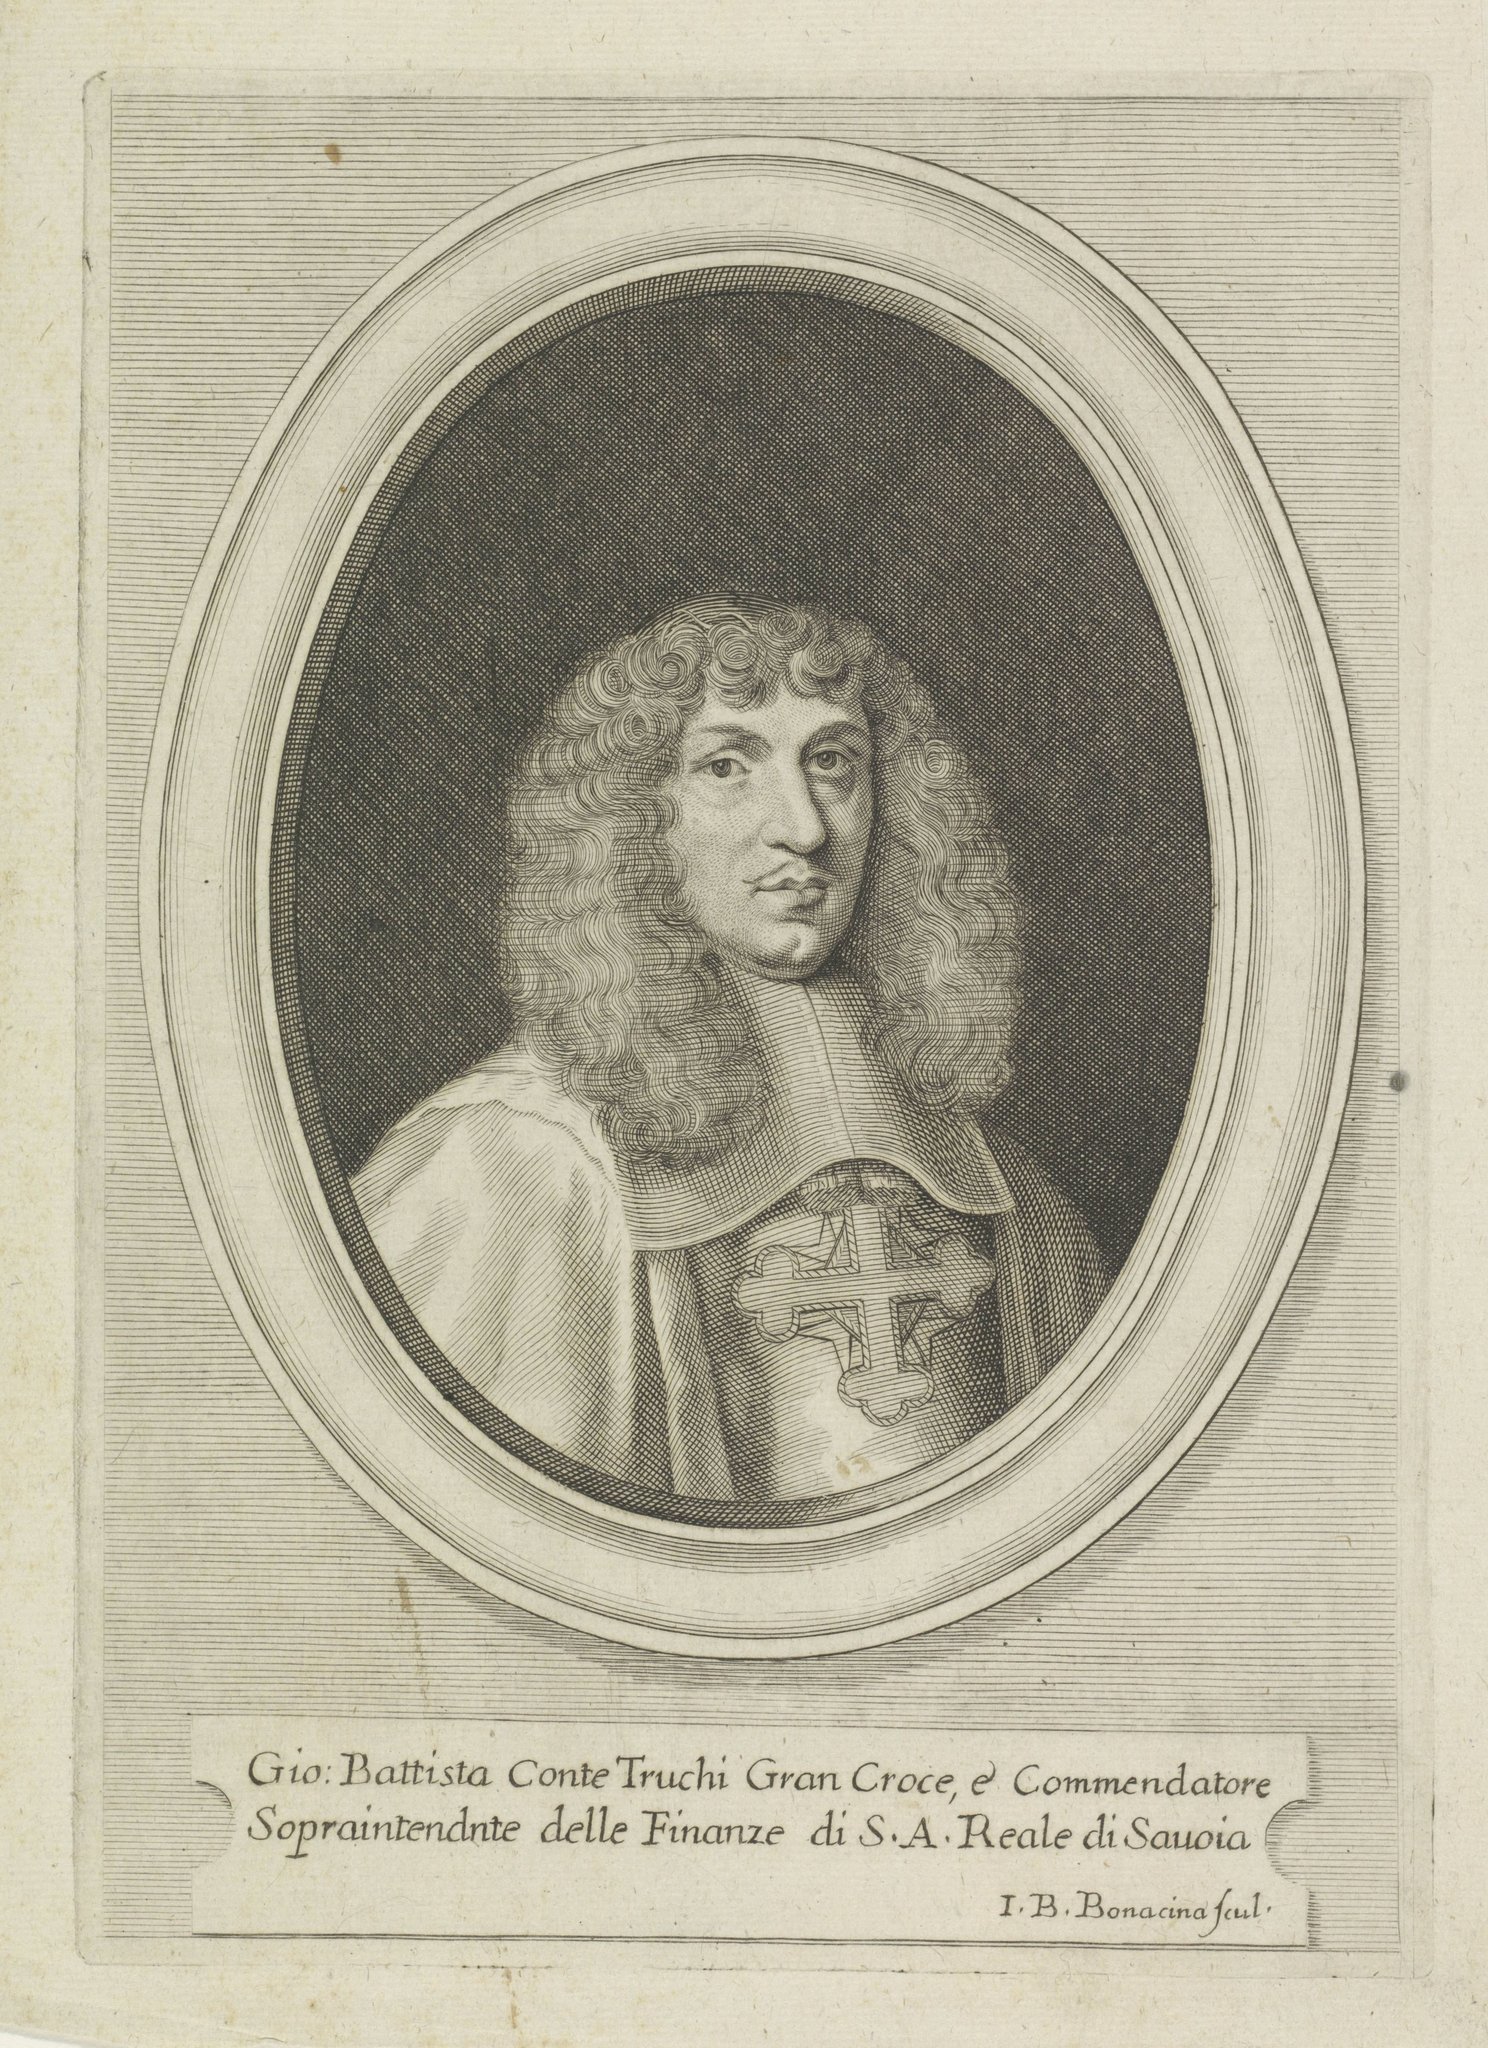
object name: print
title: Portret van Giovanni Battista Truchi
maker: giovanni battista bonacina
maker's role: print maker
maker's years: 1615-1669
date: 1625-1669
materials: paper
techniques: engraving, etching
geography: italy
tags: historical persons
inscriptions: collector's mark: Lugt 2228